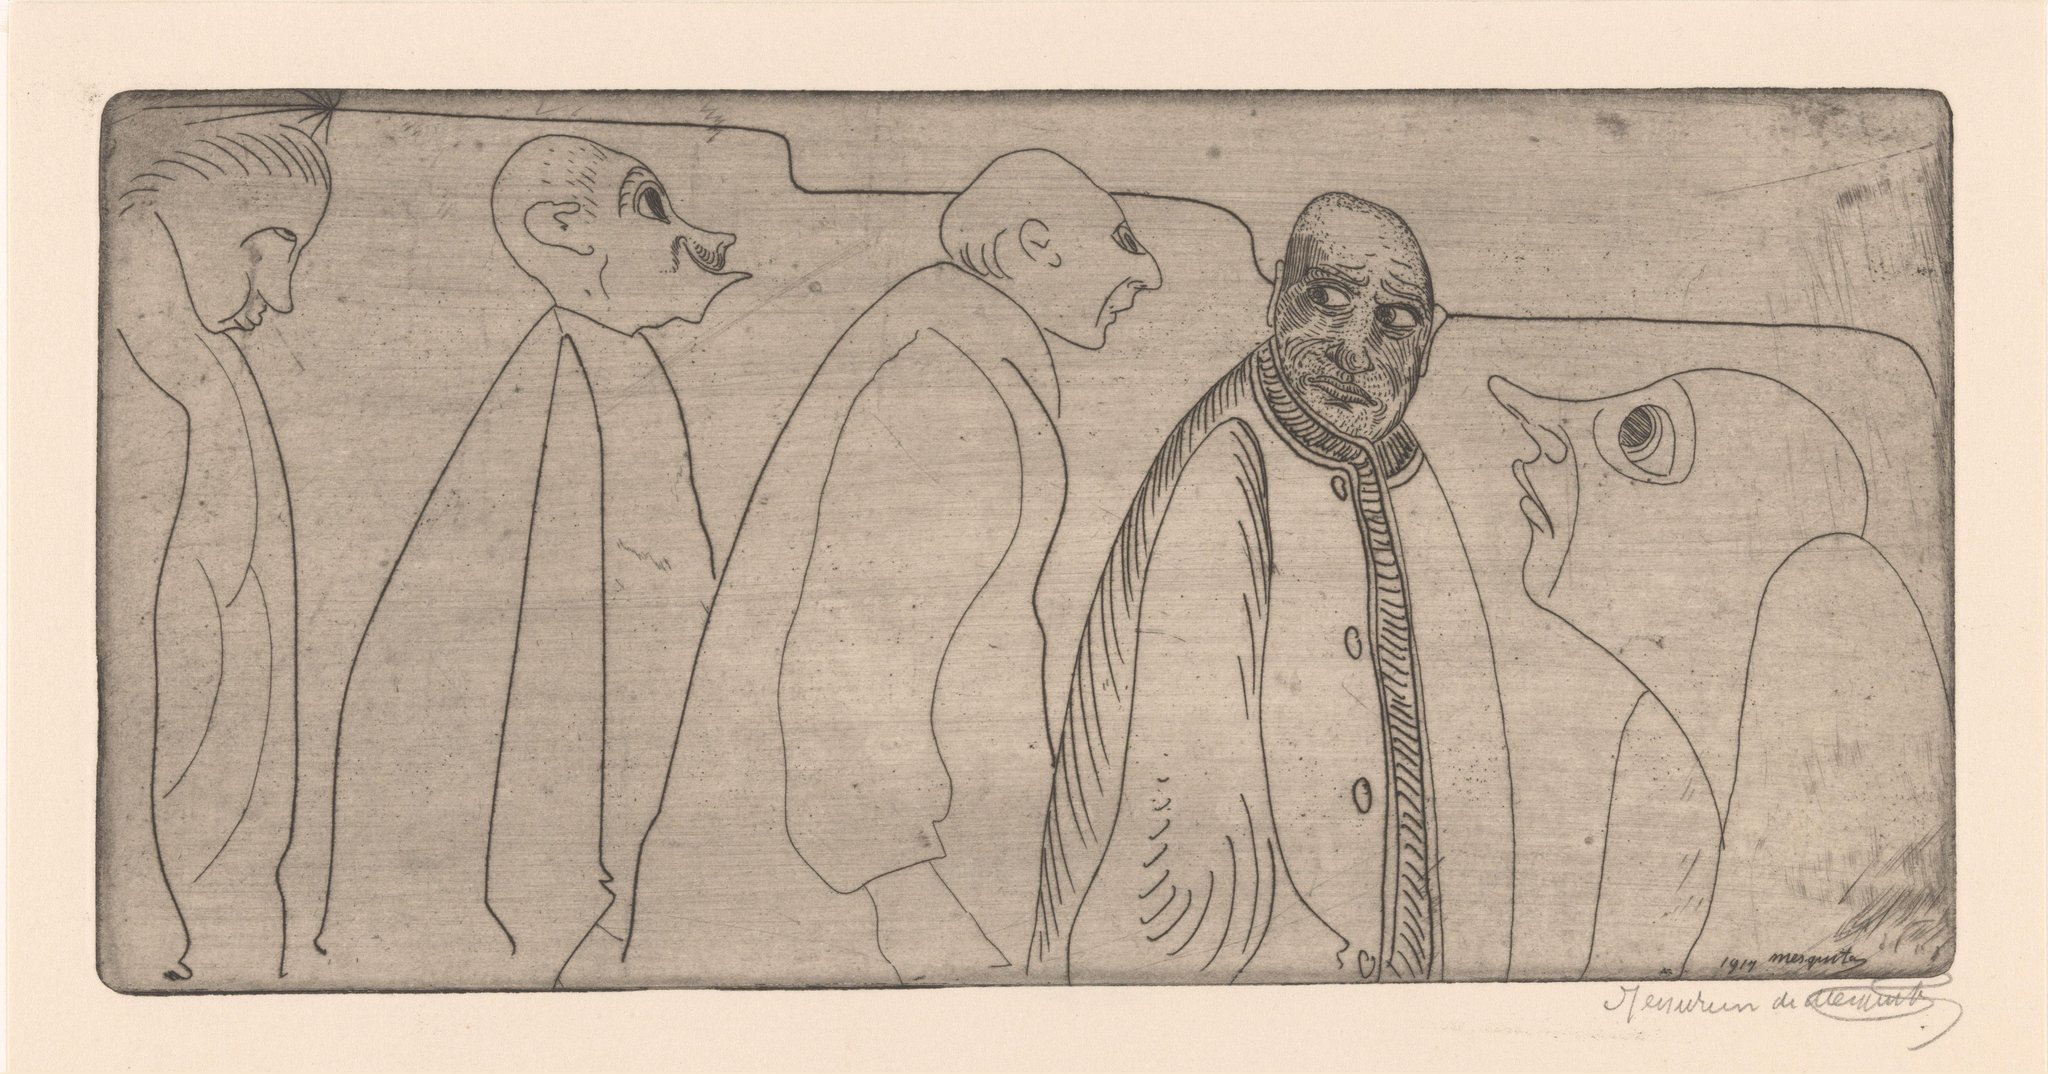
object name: print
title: Groteske verbeeldingen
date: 1917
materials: paper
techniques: etching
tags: caricatures (human types)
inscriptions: collector's mark: Lugt 2228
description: Vijf gestileerde menselijke figuren. De tweede figuur van rechts kijkt over zijn schouder.